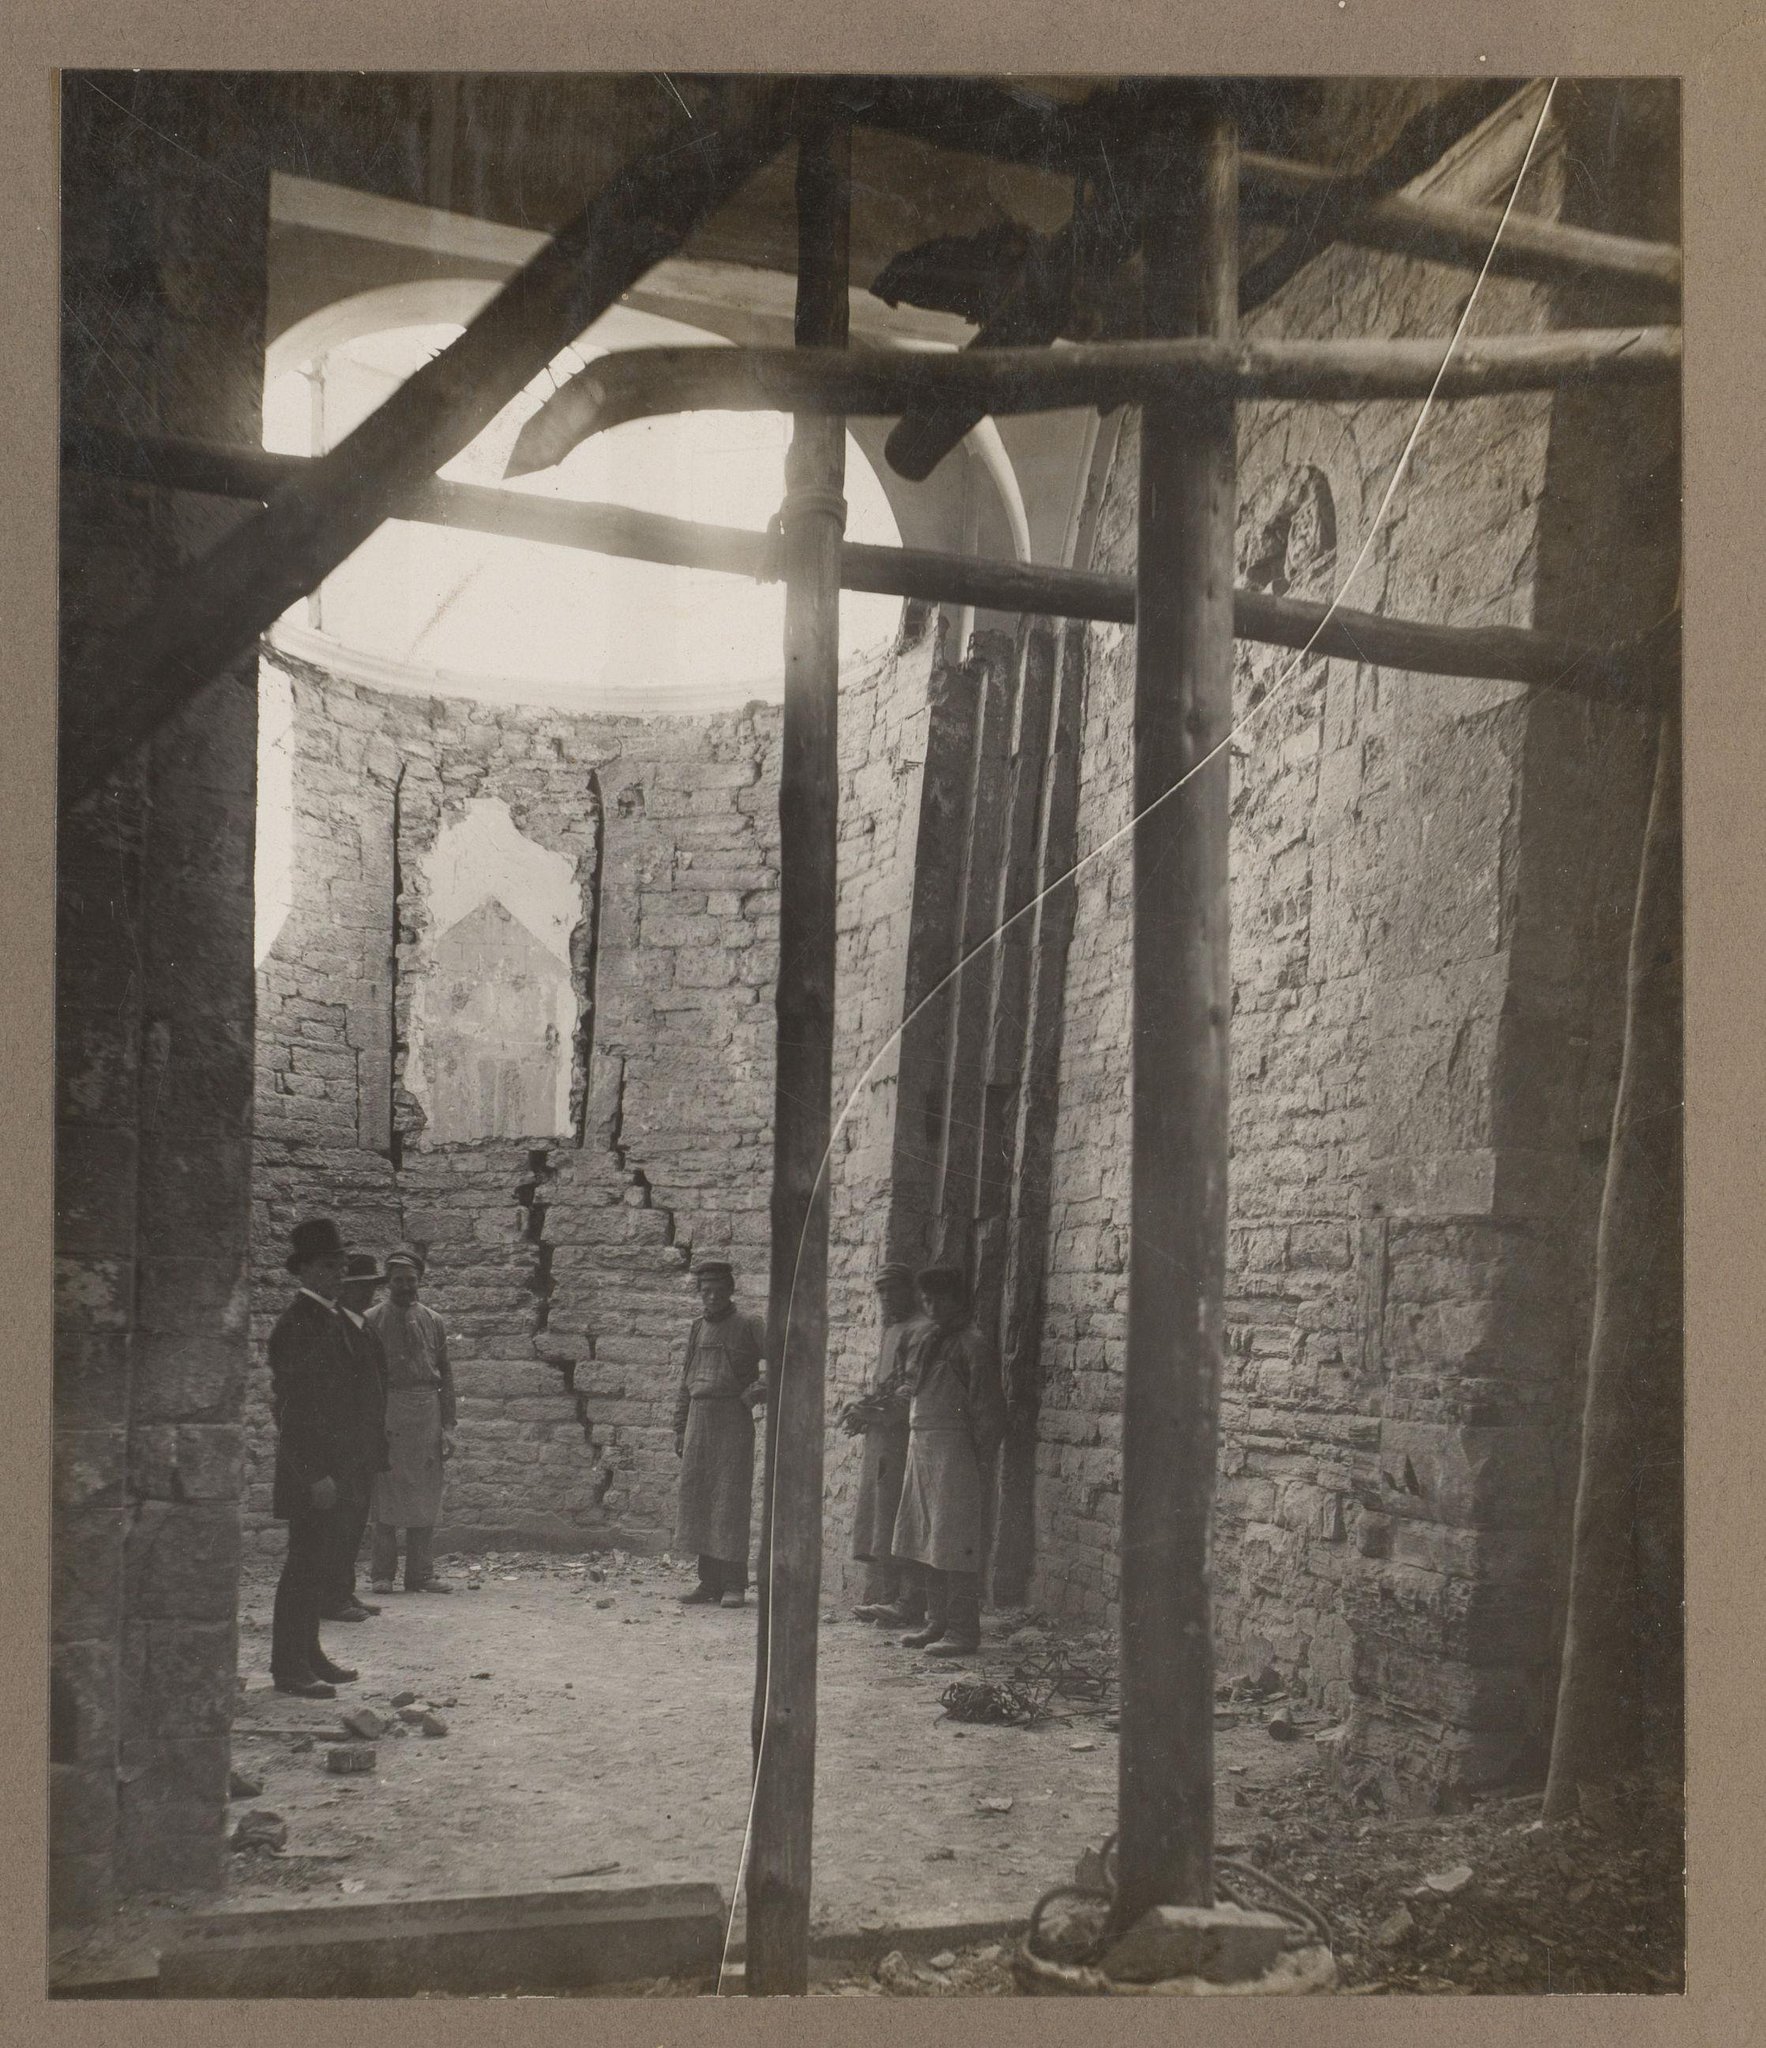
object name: photograph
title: Groep arbeiders onder een deels ingestort gewelf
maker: Anonymous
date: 1880-1920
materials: photographic support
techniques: gelatin silver print